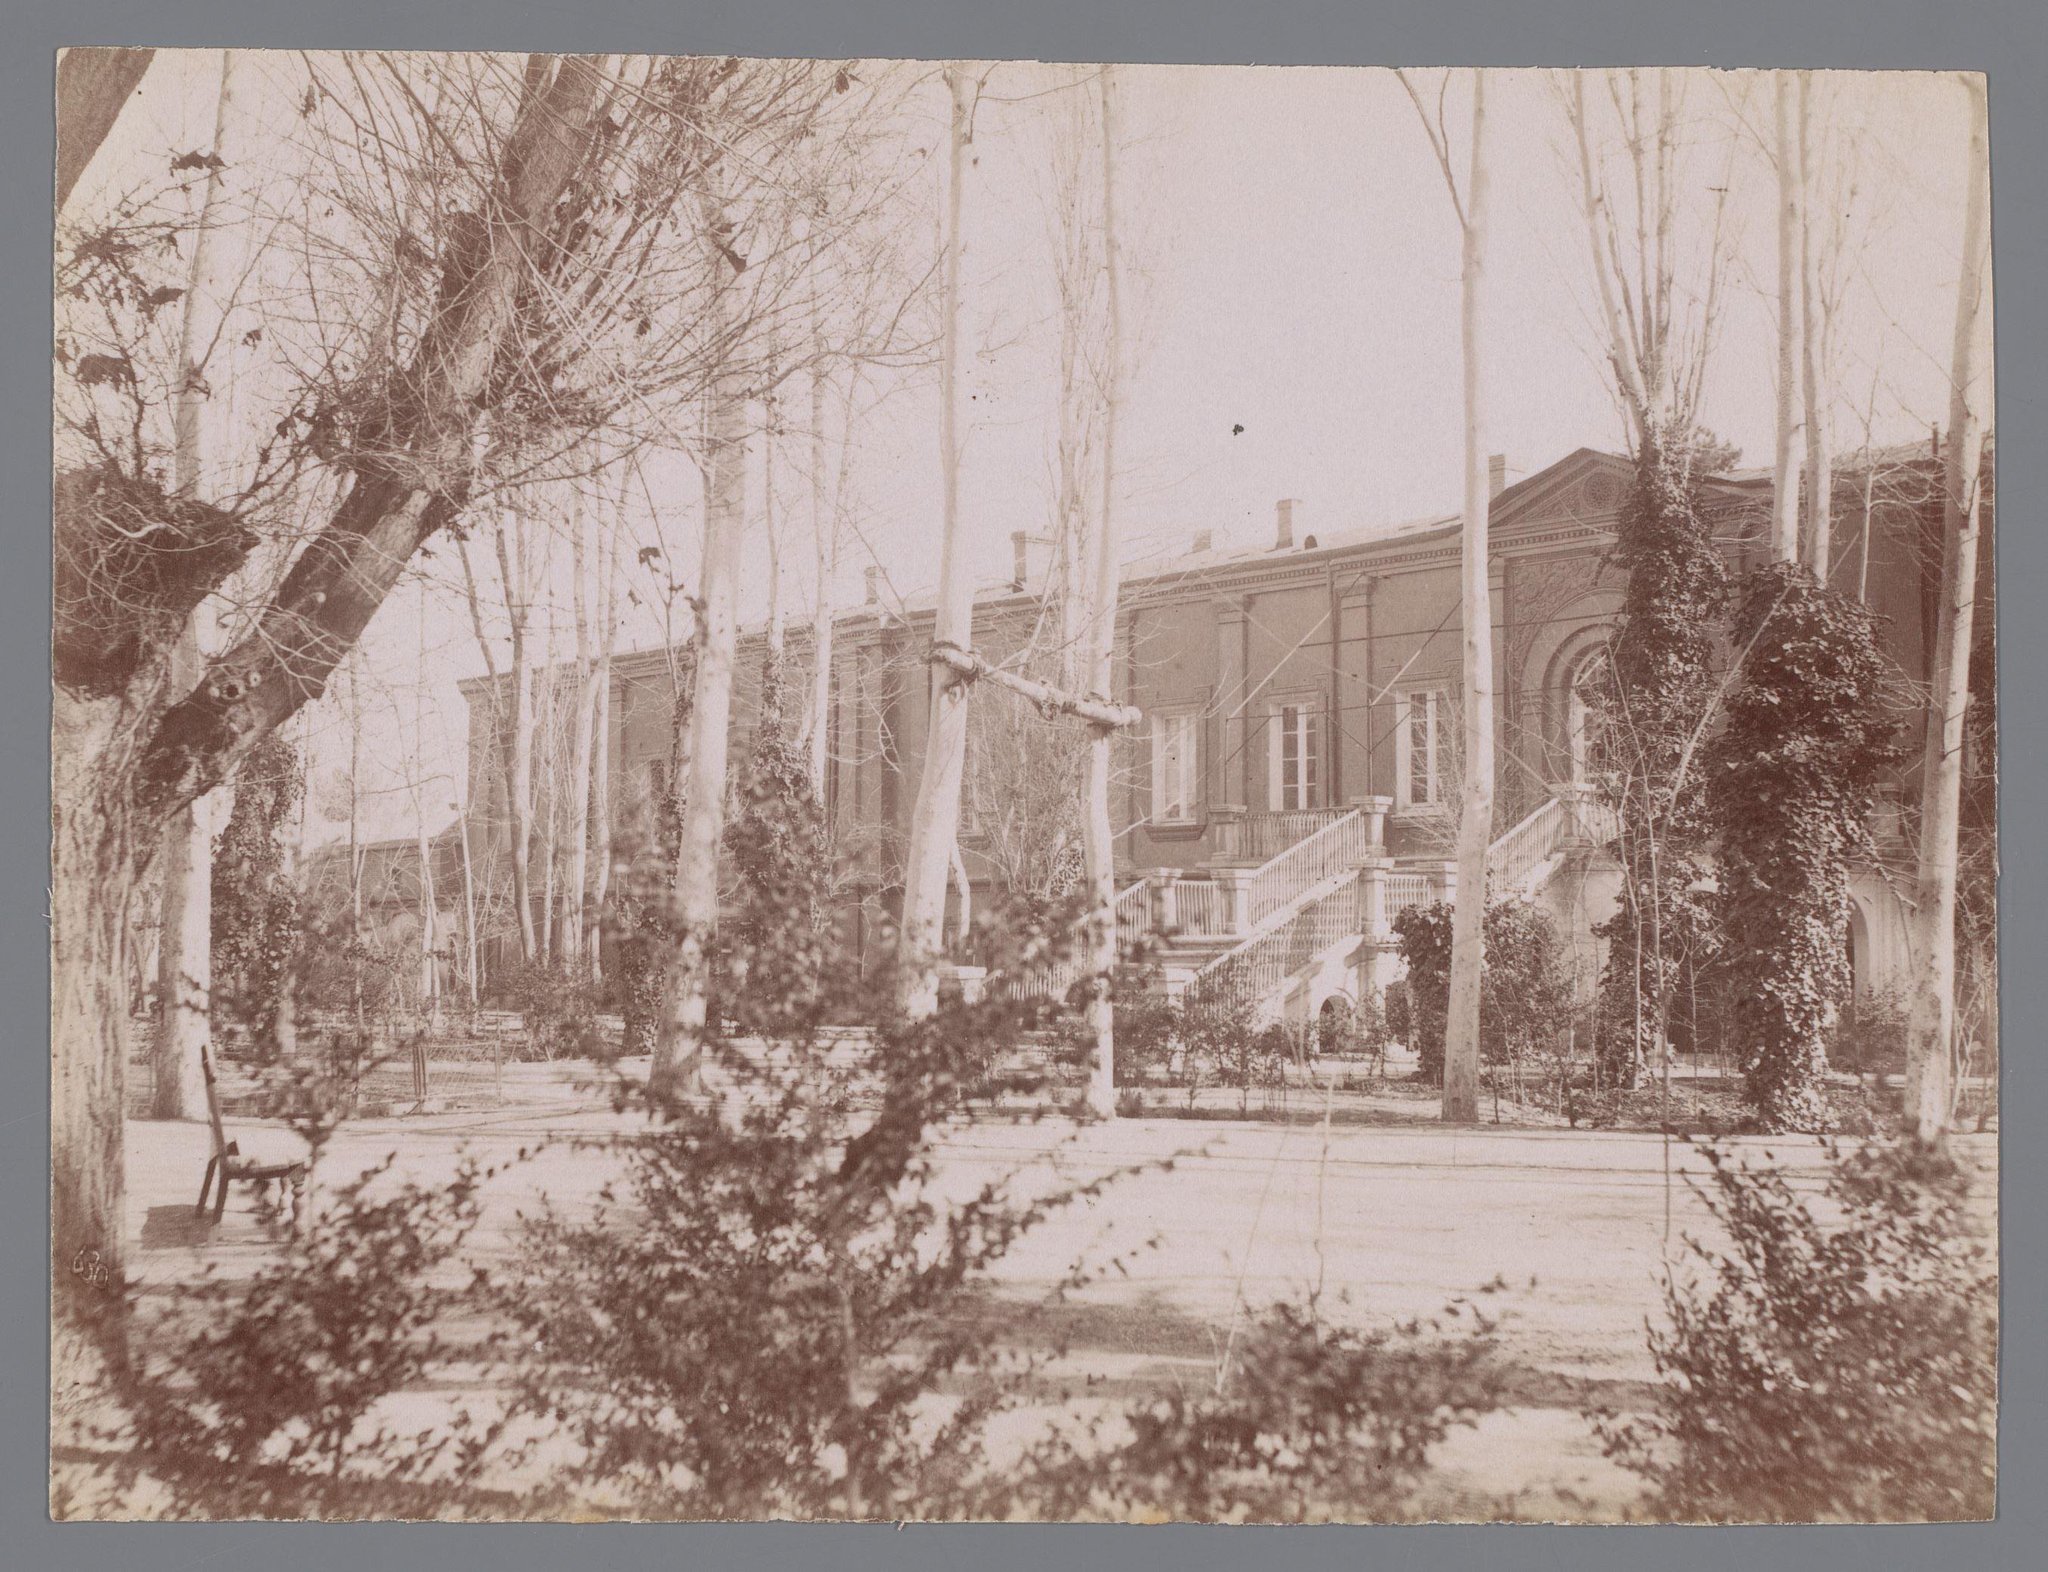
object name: photograph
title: Engels Gezantschap/ambassade, Teheran [?], Iran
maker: antoine sevruguin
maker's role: fotograaf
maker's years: 1840-1933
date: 1880-1910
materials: paper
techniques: albumen print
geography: iran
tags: teheran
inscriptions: inscription: ‘Legation Russe’, number: ‘630’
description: Engels Gezantschap/ambassade, Teheran [?], Iran.